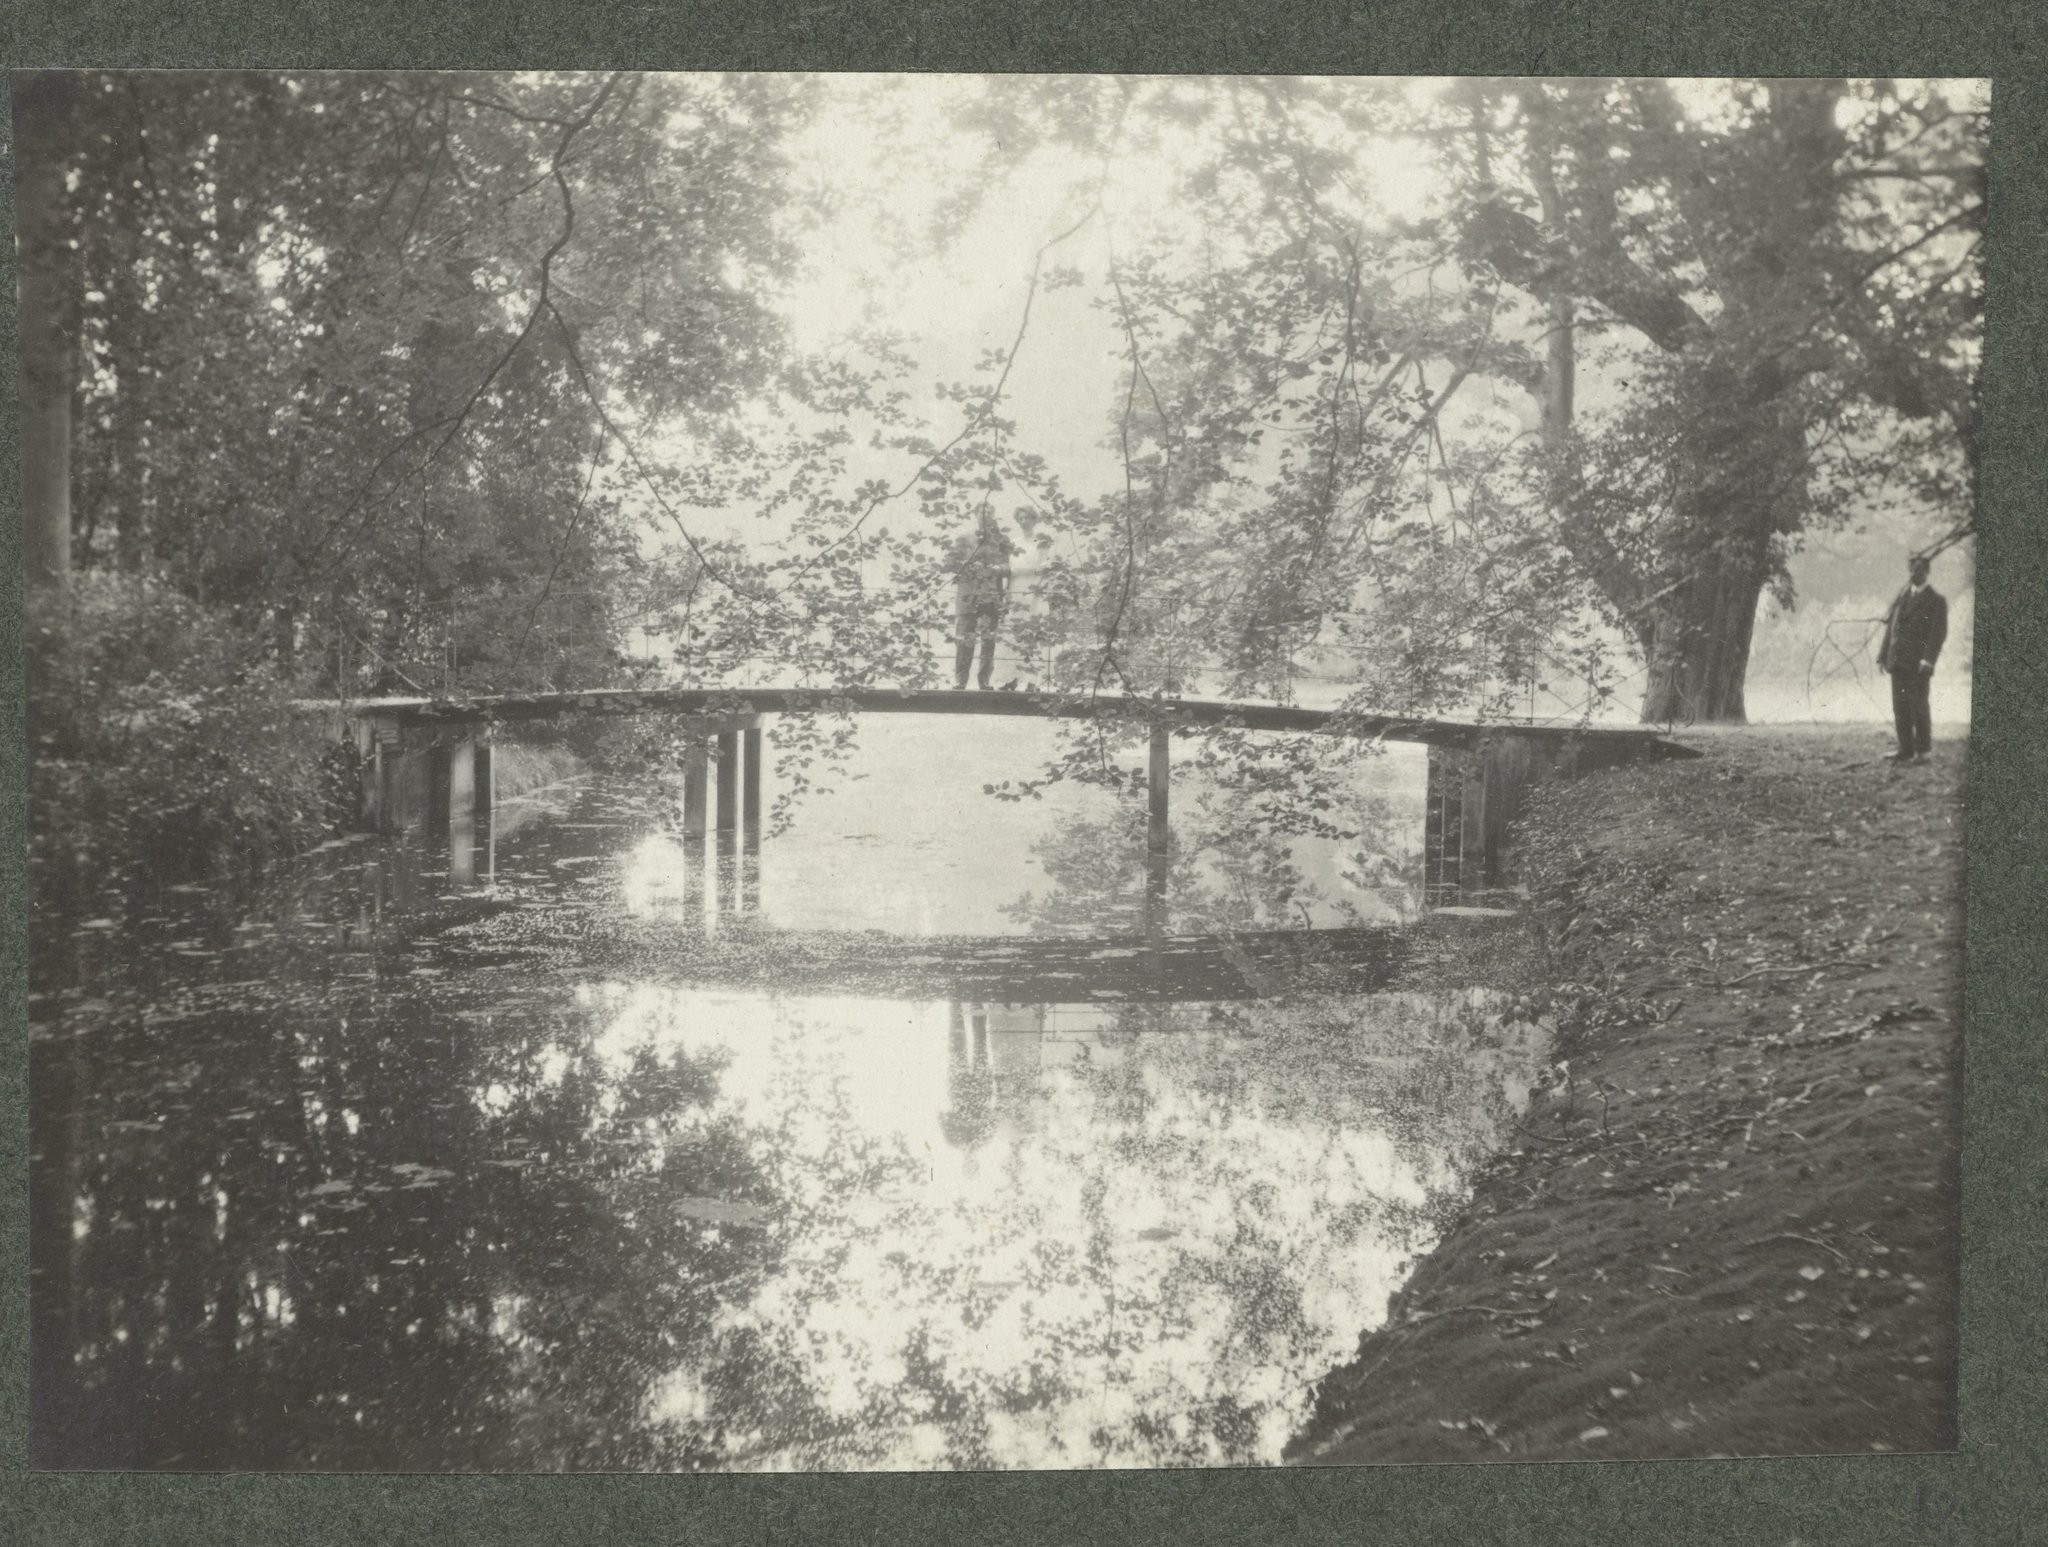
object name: photograph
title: Twee mensen poseren bij een brug over het water bij Landgoed De Paauw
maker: geldolph adriaan kessler (dolph)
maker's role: fotograaf, industrieel, voetballer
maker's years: 1884-1945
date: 1913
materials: paper, photographic support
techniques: photography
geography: netherlands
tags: huize de paauw